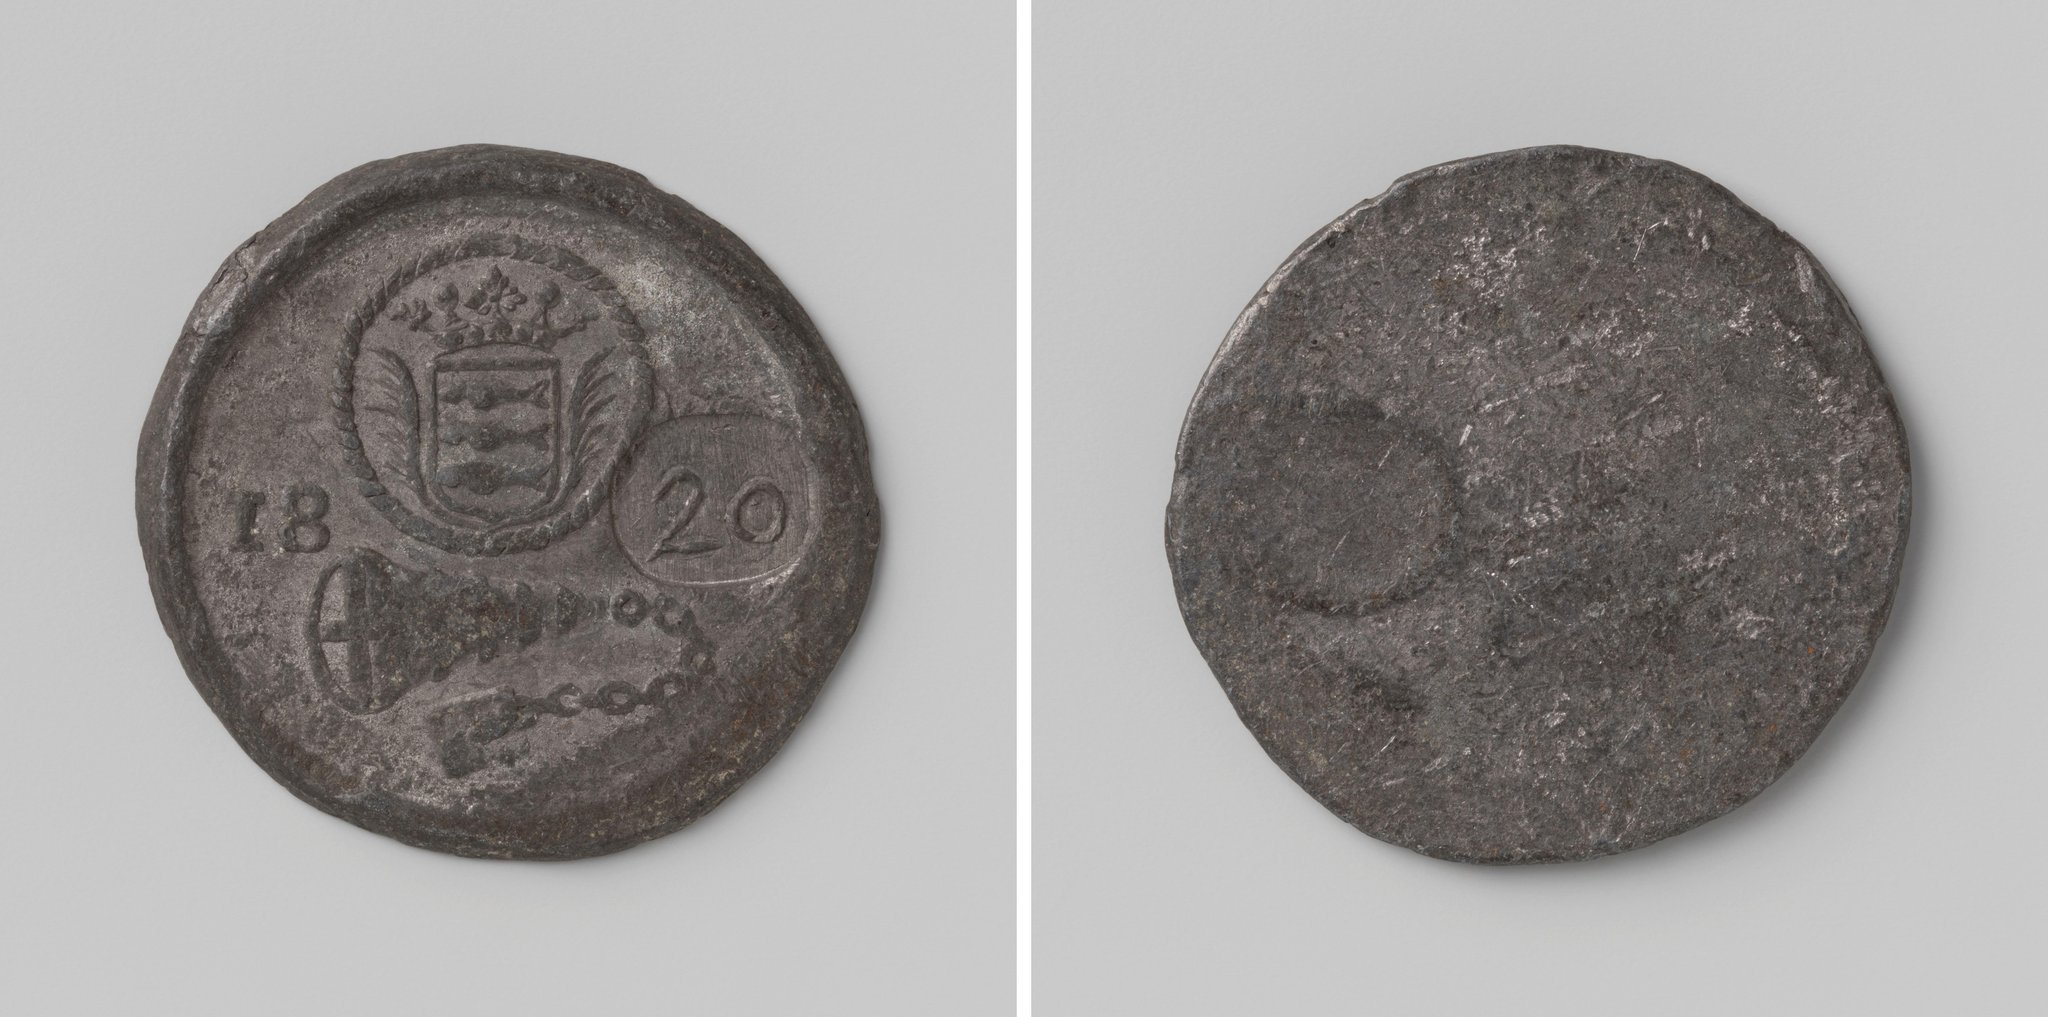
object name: tonnegeld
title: Stad Enkhuizen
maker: Anonymous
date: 1820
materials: lead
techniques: striking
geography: enkhuizen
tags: enkhuizen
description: eenzijdig, niet geheel rond loodje. Voorzijde: gekroond wapenschild op twee gekruiste takken binnen ronde kabelrand; daaronder: stempel tussen jaartal. Keerzijde: blanco